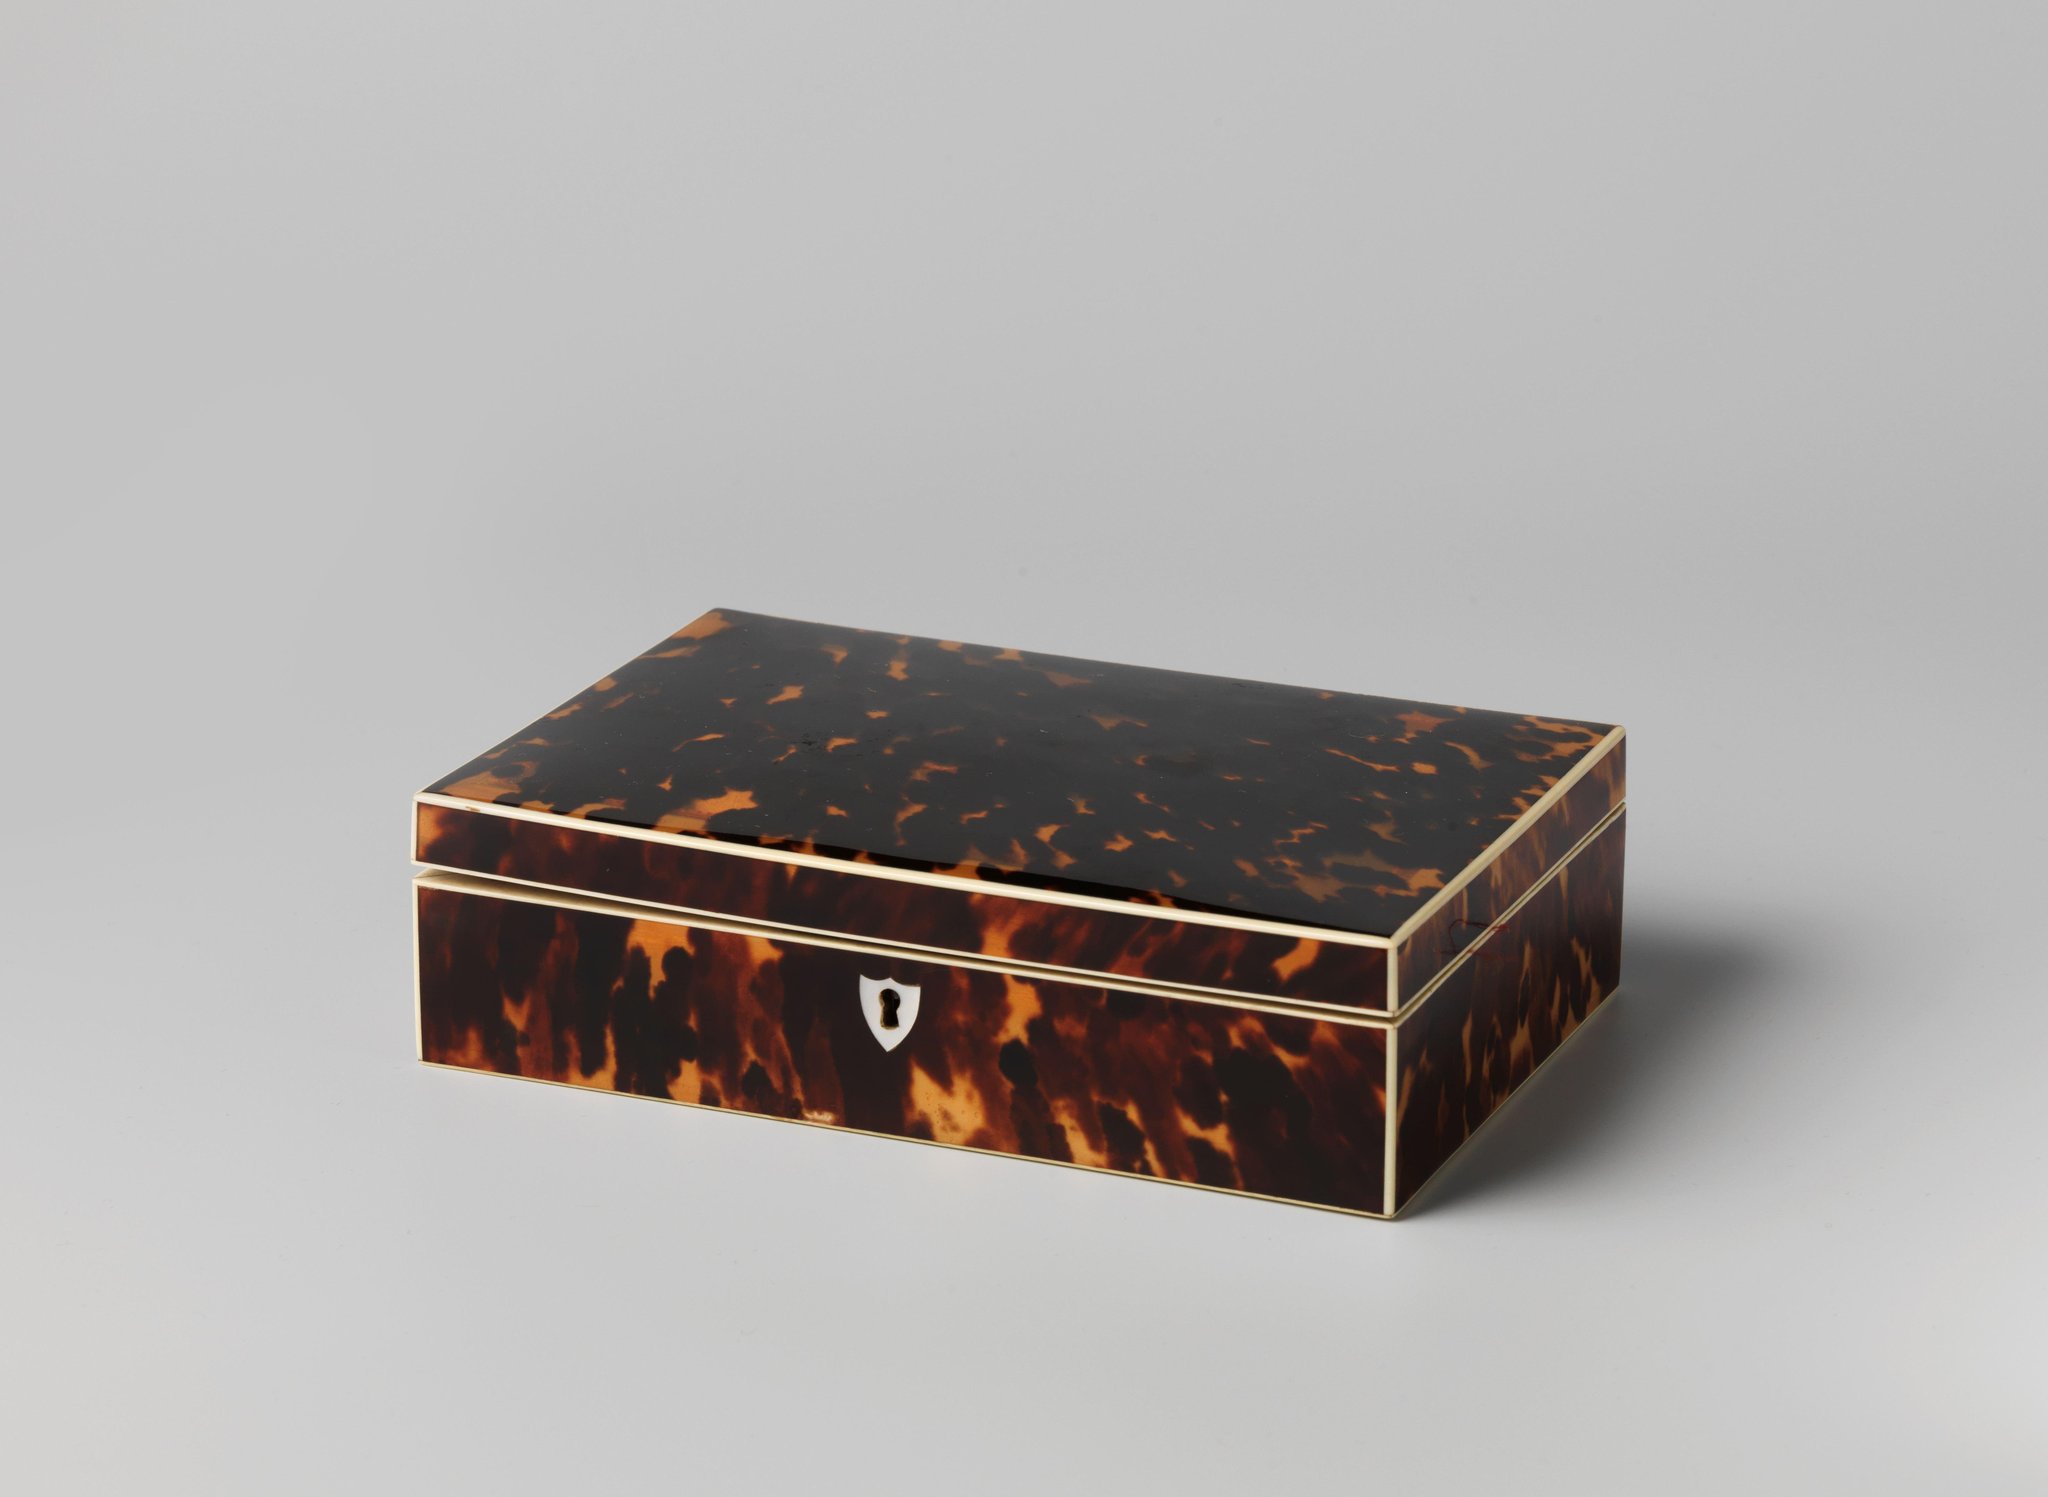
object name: sewing kit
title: Naaidoos met inhoud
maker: Anonymous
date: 1400-1950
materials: gold, ivory, mother of pearl, shell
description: Naaidoos van schildpad met randen van ivoor. Inhoud een achtdelig naaigarnituur van goud, bestaande uit: twee sterretjes, een naaldenkoker, een schaar, een vingerhoed, een doosje met 2 fiches van paarlemoer, een priem en een flacon (aparte beschrijvingen volgen nog).